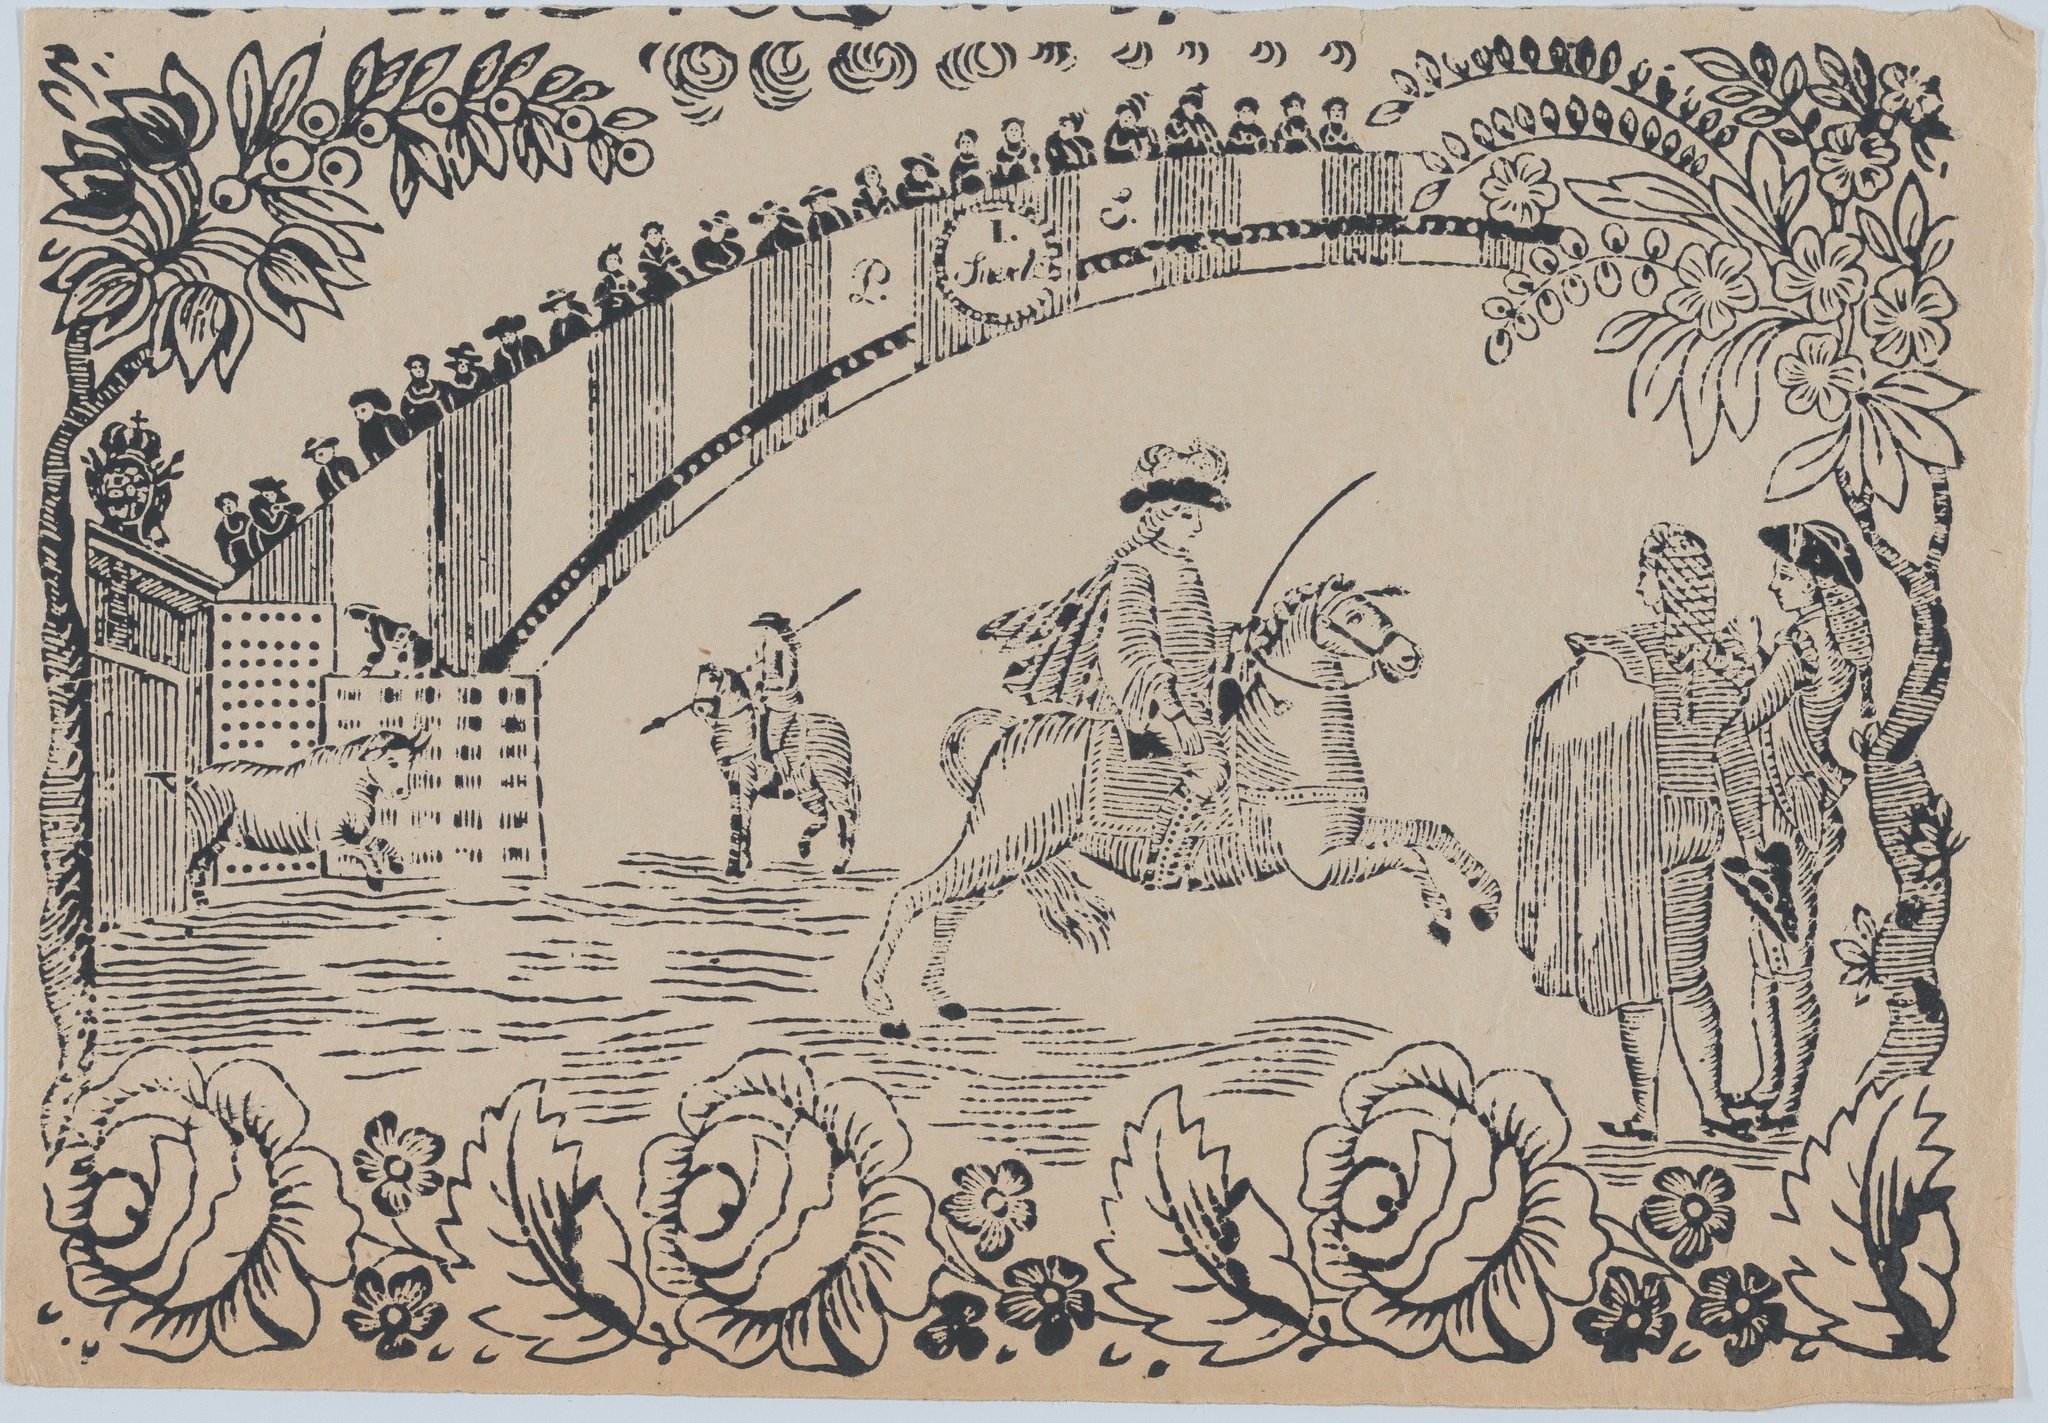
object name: print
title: Suerte I: Bull entering the bullring after a law officer on horseback; two toreros standing to right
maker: anonymous, spanish, 19th century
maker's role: artist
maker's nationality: spanish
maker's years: 1800-1900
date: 1850-1880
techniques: woodcut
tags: men,bulls,horses,flowers